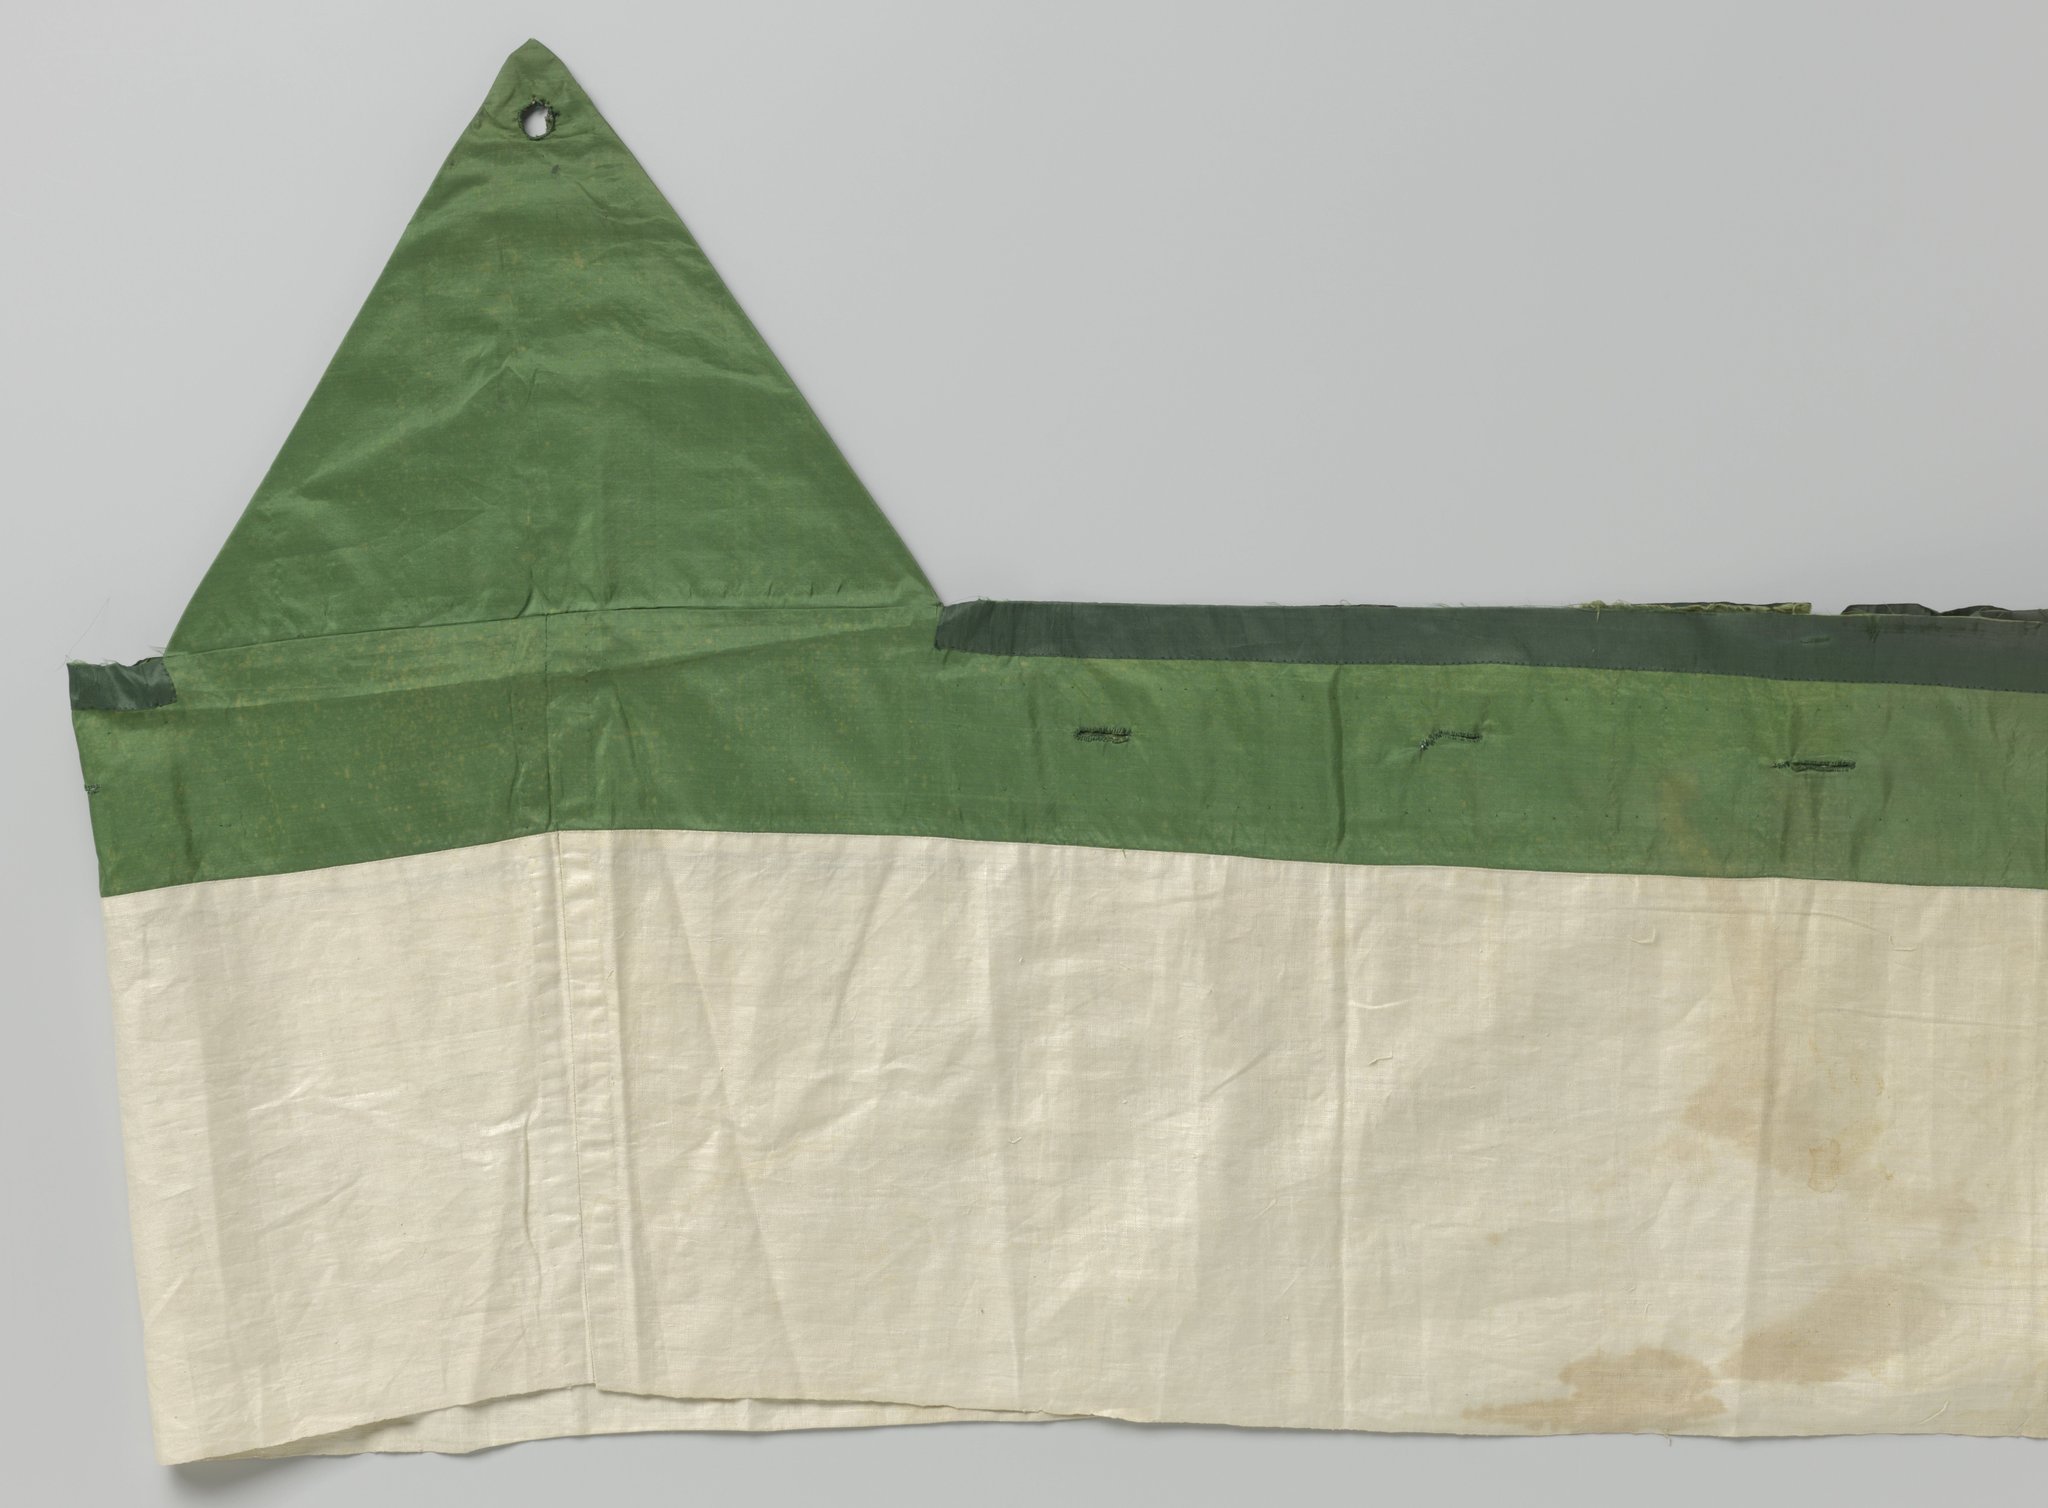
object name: strip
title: Strook groen zijde met knoopsgaten.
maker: Anonymous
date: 1700-1800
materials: linen, silk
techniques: weave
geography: netherlands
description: Strook groene zijde met knoopsgaten. Aan de strook is een strook wit linnen vastgenaaid. De strook heeft een linnen voering.